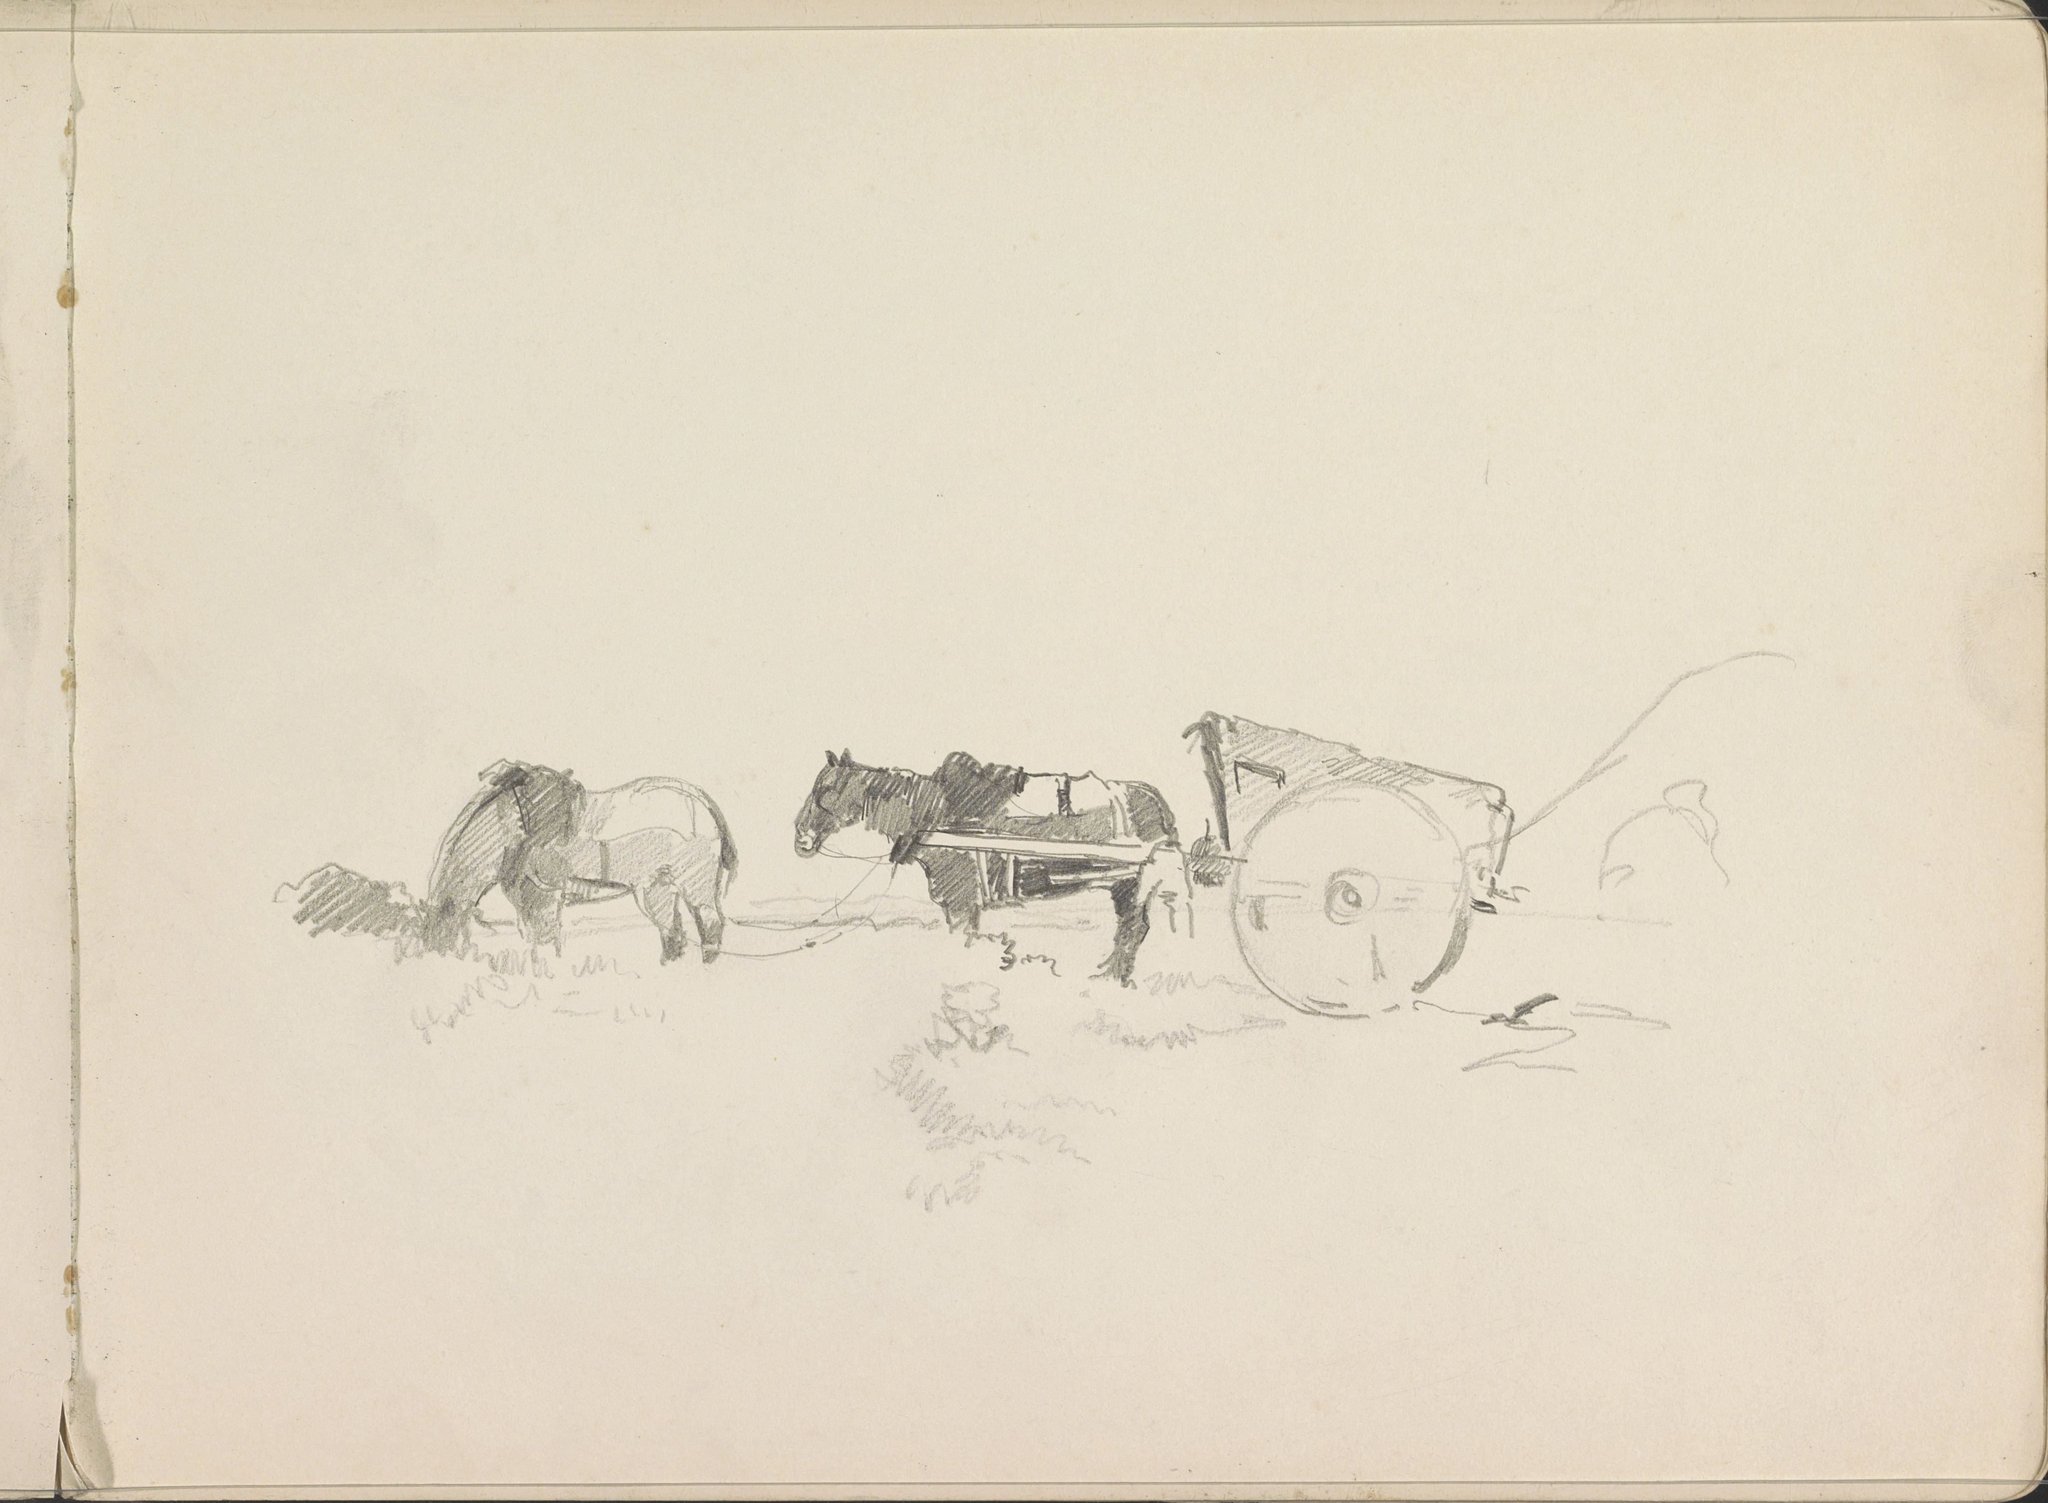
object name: sketchbook leaf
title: Grazend paard en een paardenkar in een landschap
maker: cornelis vreedenburgh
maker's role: draughtsman, print maker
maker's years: 1880-1946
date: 1890-1946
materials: paper, pencil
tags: landscapes, horse, (farm) wagon, freight wagon, cart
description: Blad 3 recto uit een schetsboek met 23 bladen.